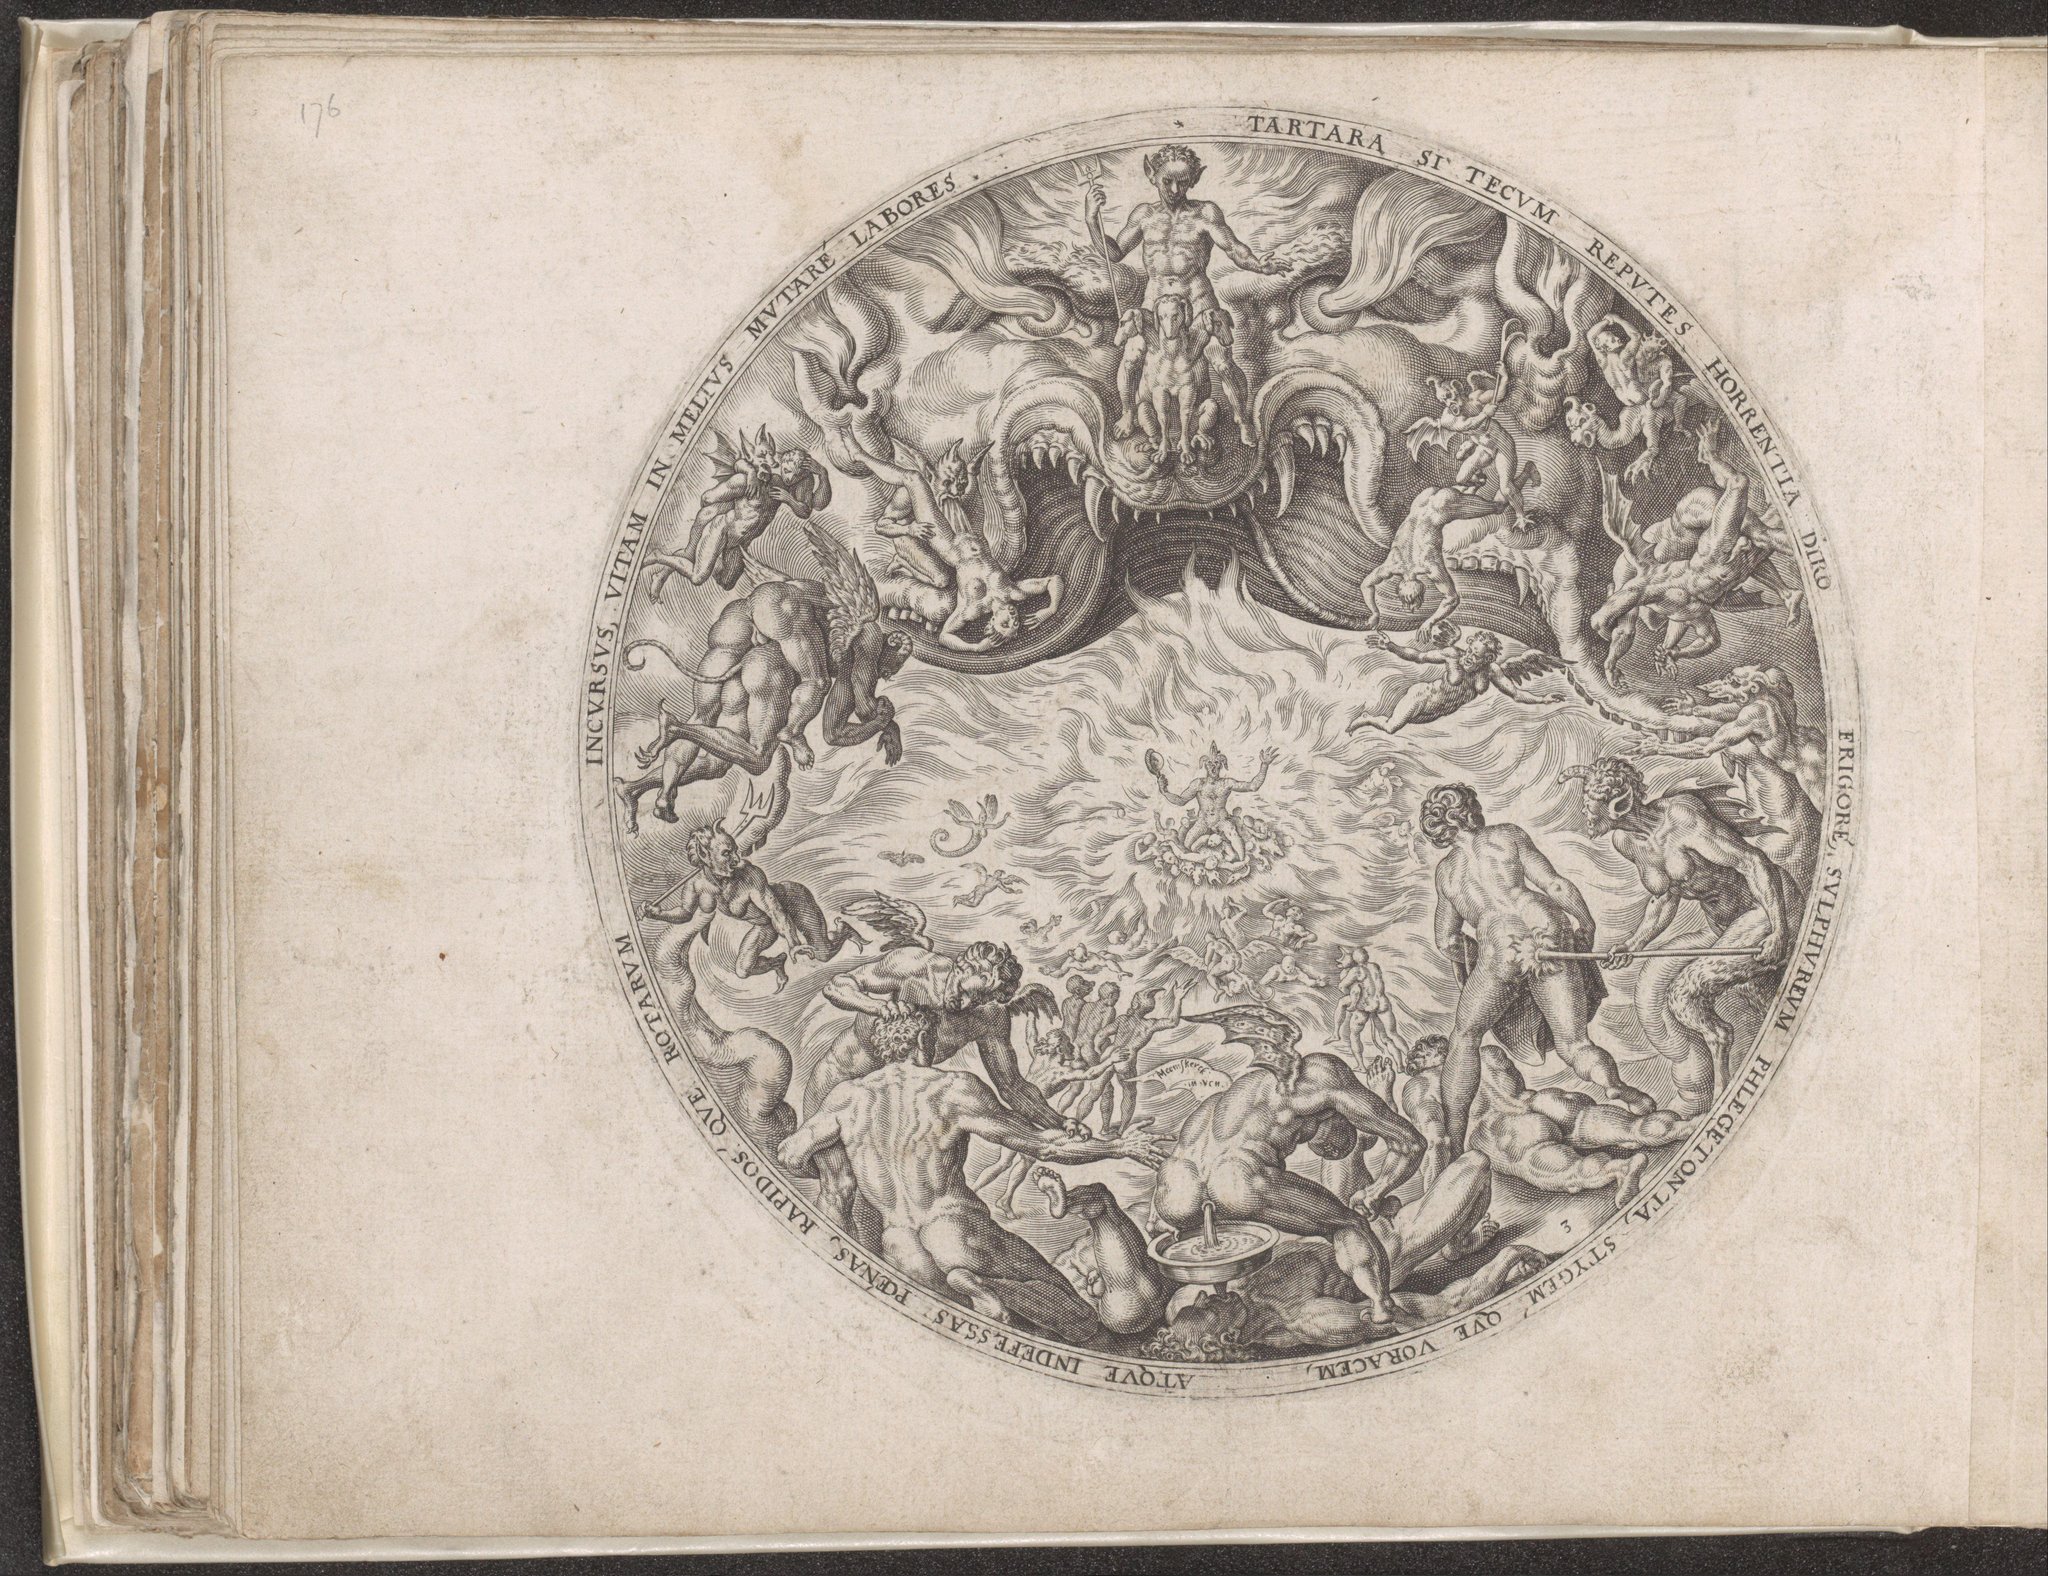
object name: print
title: Hel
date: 1569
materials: paper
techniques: engraving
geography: haarlem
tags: representations of hell (with the damned and devils), usually with burning fires - tt - with the devil (lucifer) as ruler, devil(s) and demons, the damned souls beaten, pricked, scourged, etc. by devils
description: De hel met in het midden vuur. Satan zit met een drietand in de hand met de driekoppige hond Cerberus boven de hellemond. Verdoemden worden door duivels en demonen gepijnigd en gemarteld. Rond de voorstelling een randtekst in het Latijn. Deze prent maakt deel uit van een album.